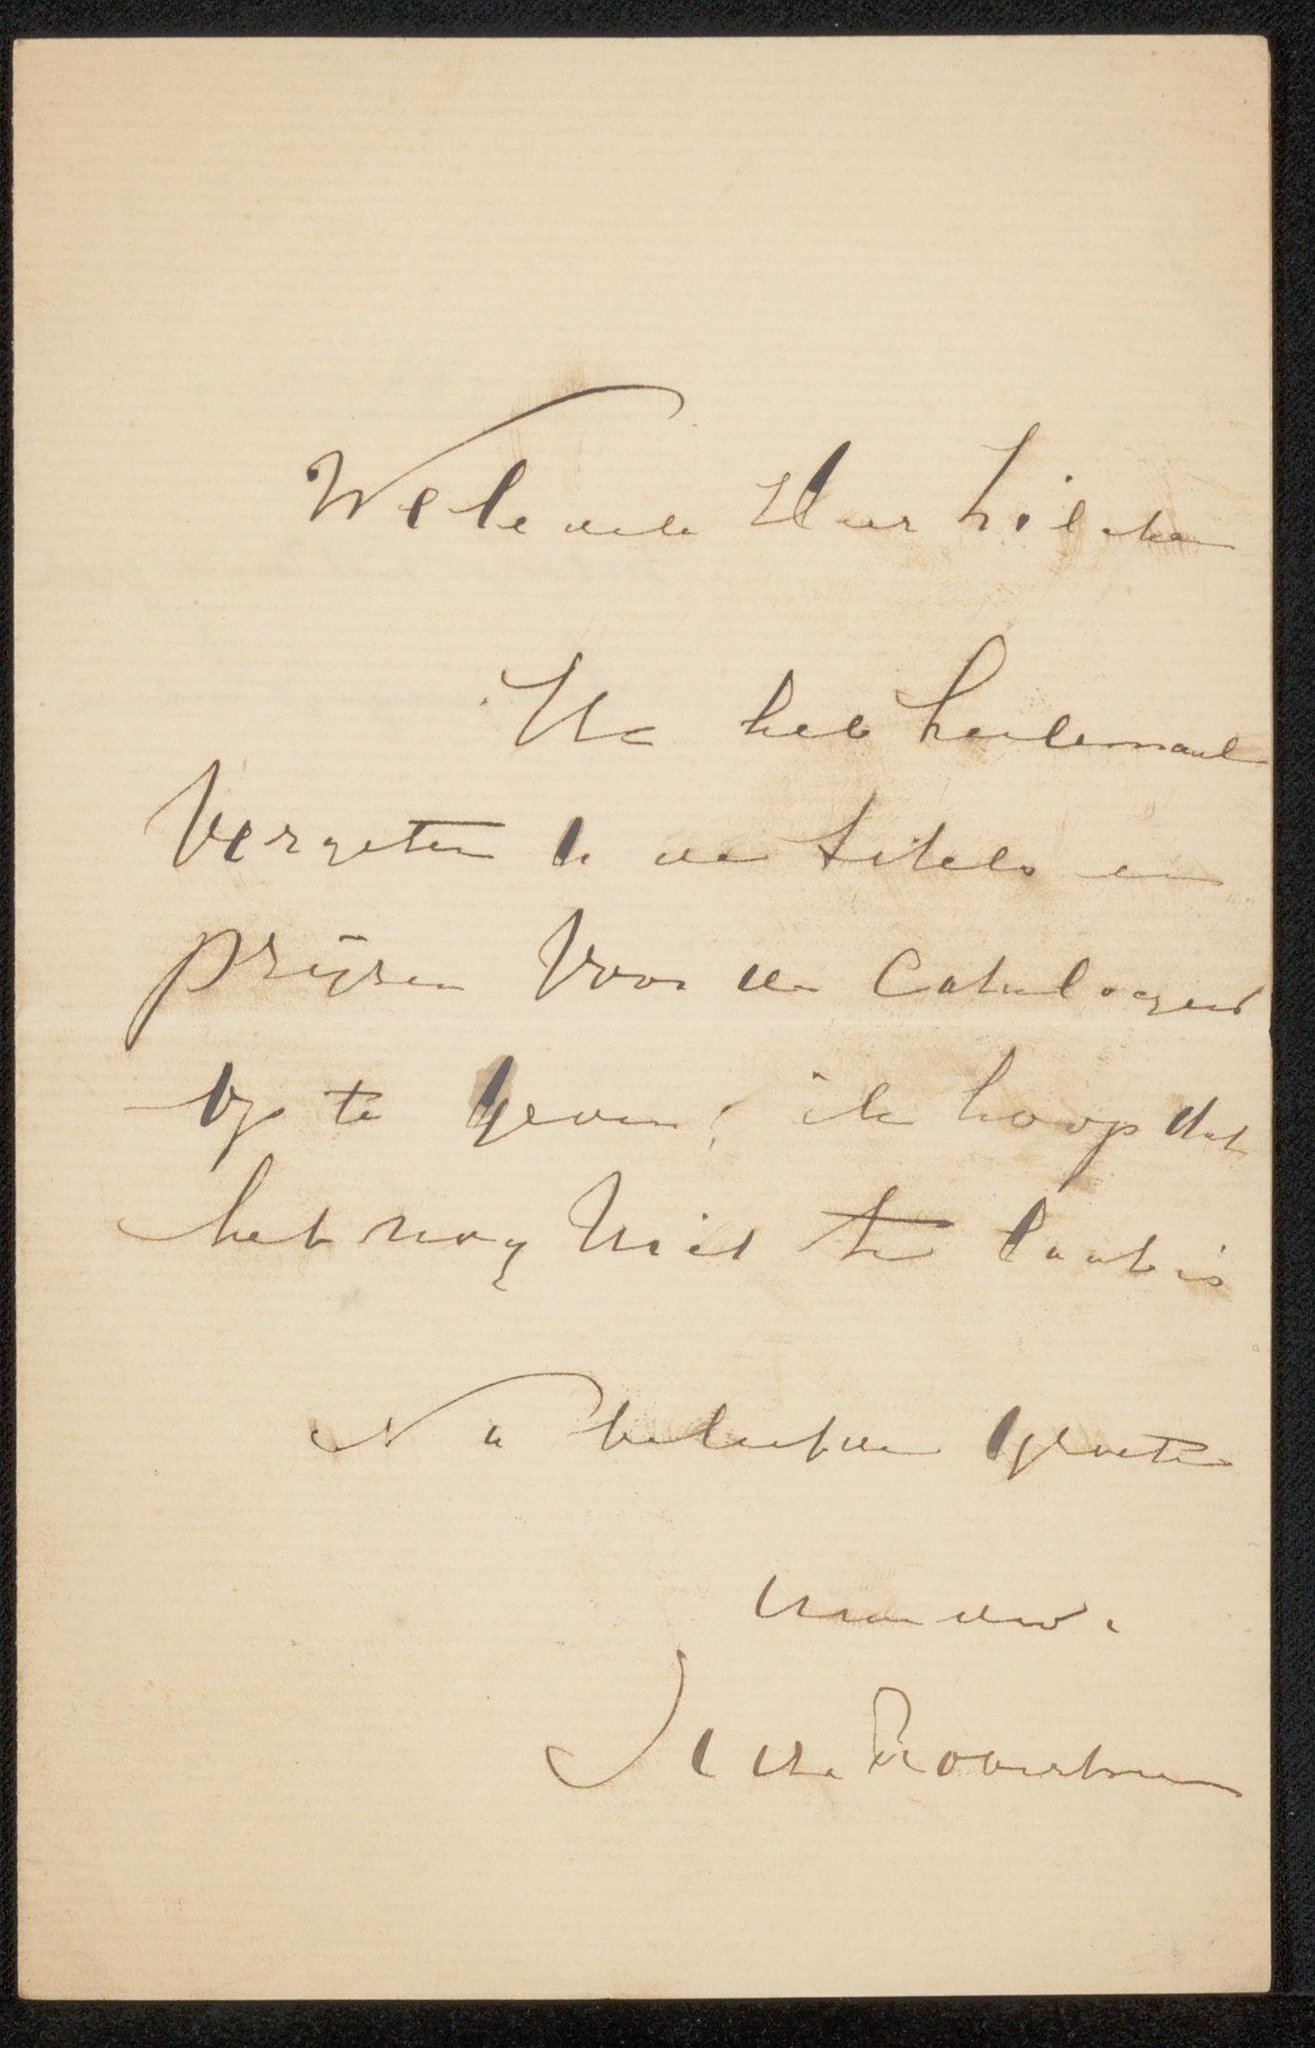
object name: letter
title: Brief aan Philip Zilcken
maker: suze robertson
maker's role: draughtsman, painter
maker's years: 1855-1922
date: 1865-1922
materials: ink, paper, pencil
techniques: pen, writing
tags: the hague, painter, draughtsman, philip zilcken, drawing, money, printed matter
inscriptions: collector's mark: ‘RPK’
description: Brief bevat aantekening van Philip Zilcken.